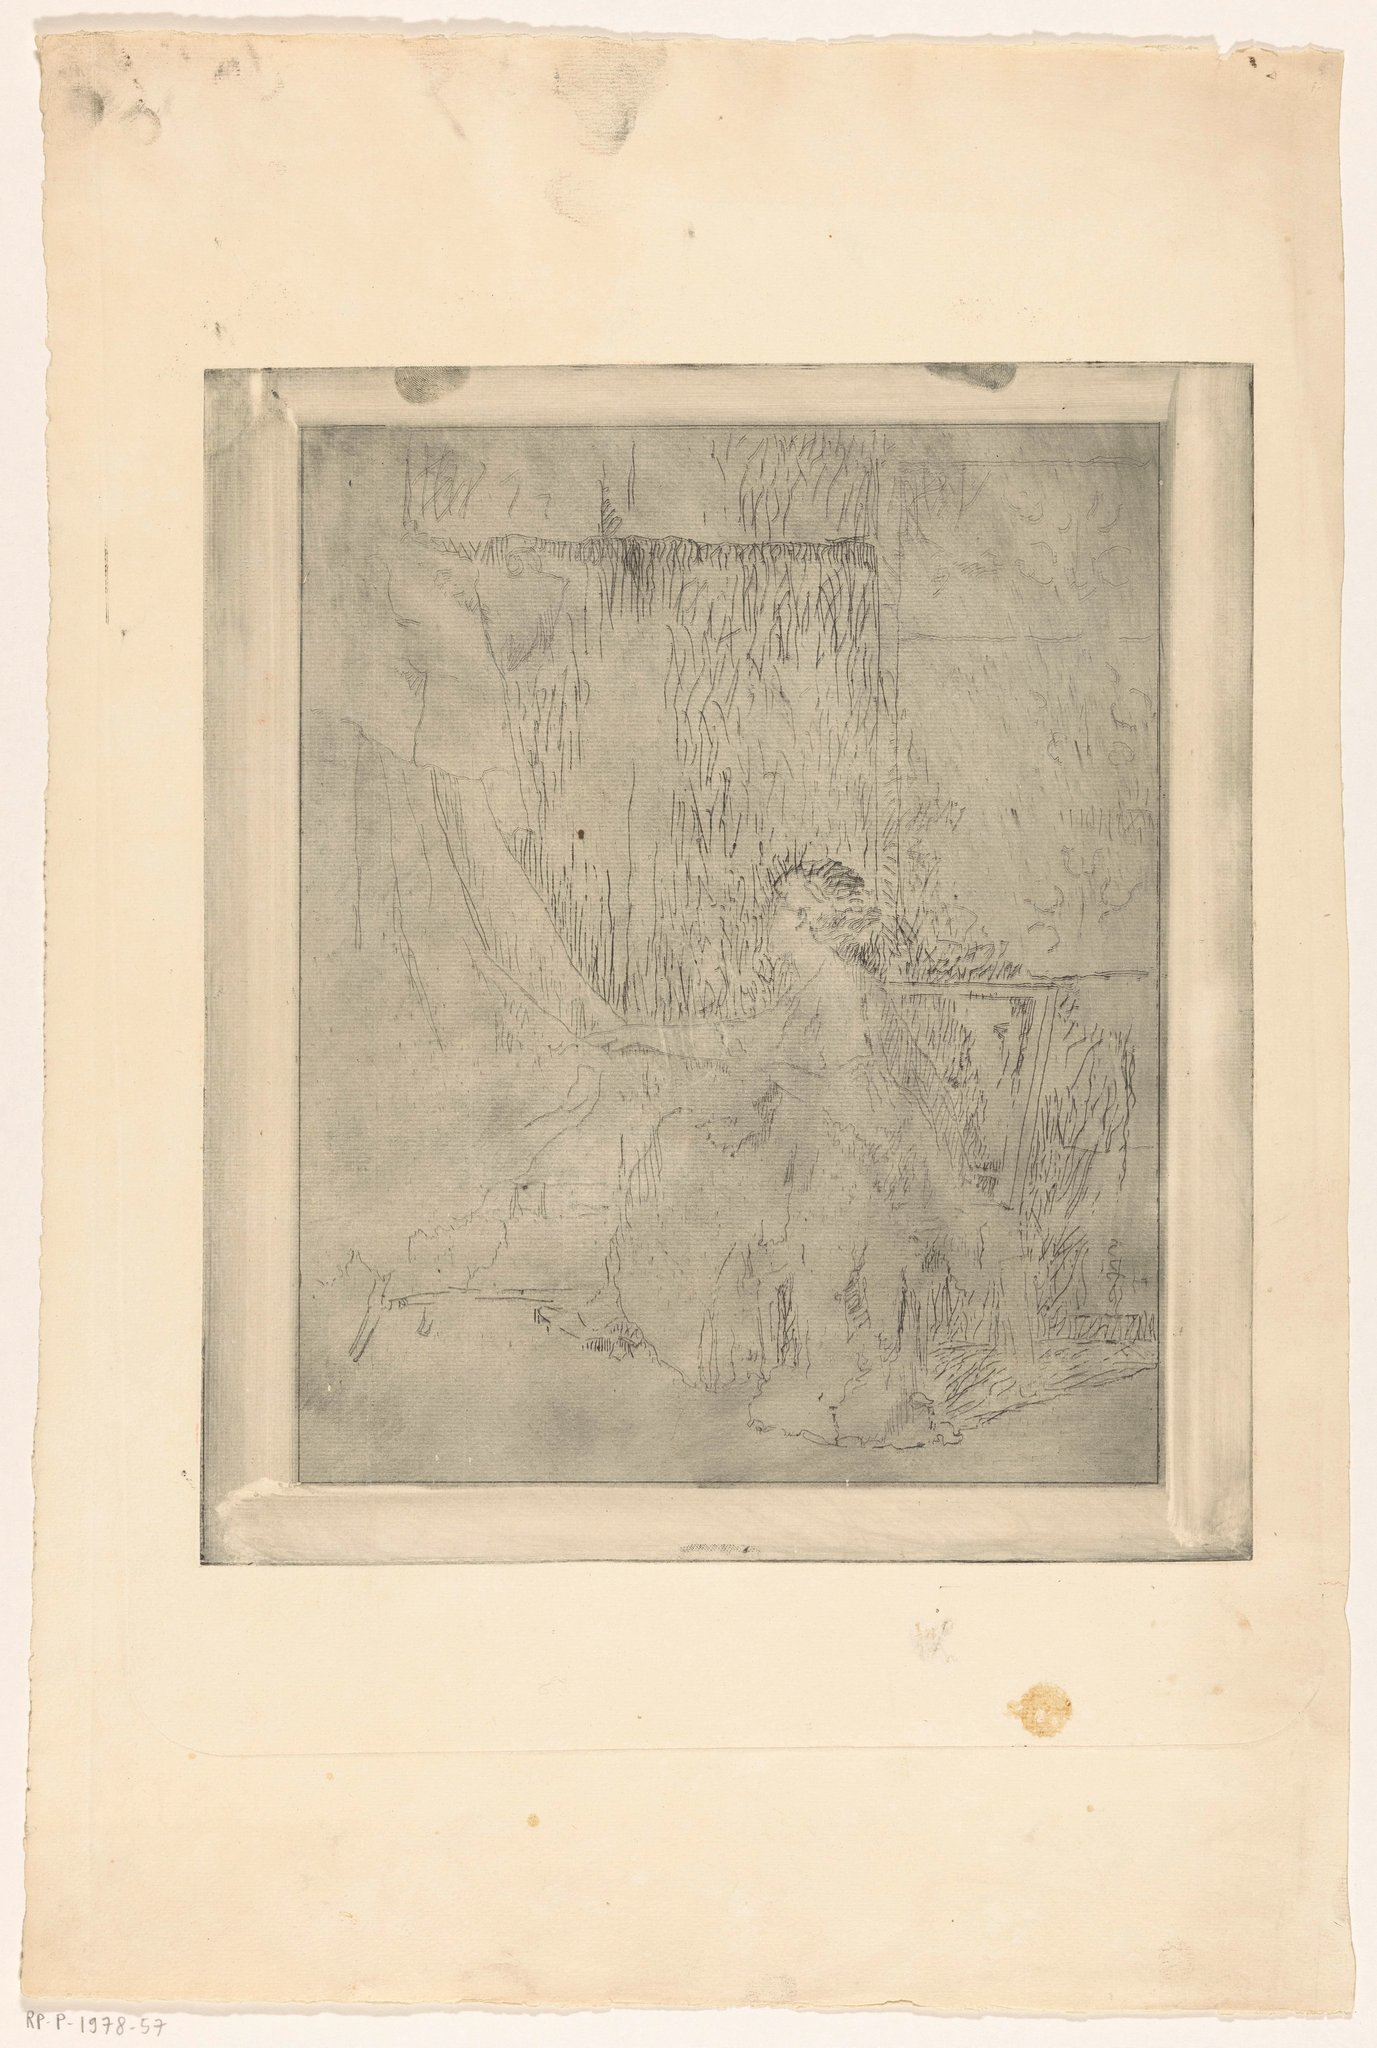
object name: print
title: Vrouw die op een stoel naast een wieg zit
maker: albert roelofs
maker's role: print maker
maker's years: 1877-1920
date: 1887-1920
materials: paper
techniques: etching, intaglio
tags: cradle, crib, mother and child(ren), woman and child(ren) (family group)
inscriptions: collector's mark: Lugt 2760, collector's mark: Lugt 2228, number: ‘1219 / 21’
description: De vrouw leunt met haar arm op de rand van de wieg.